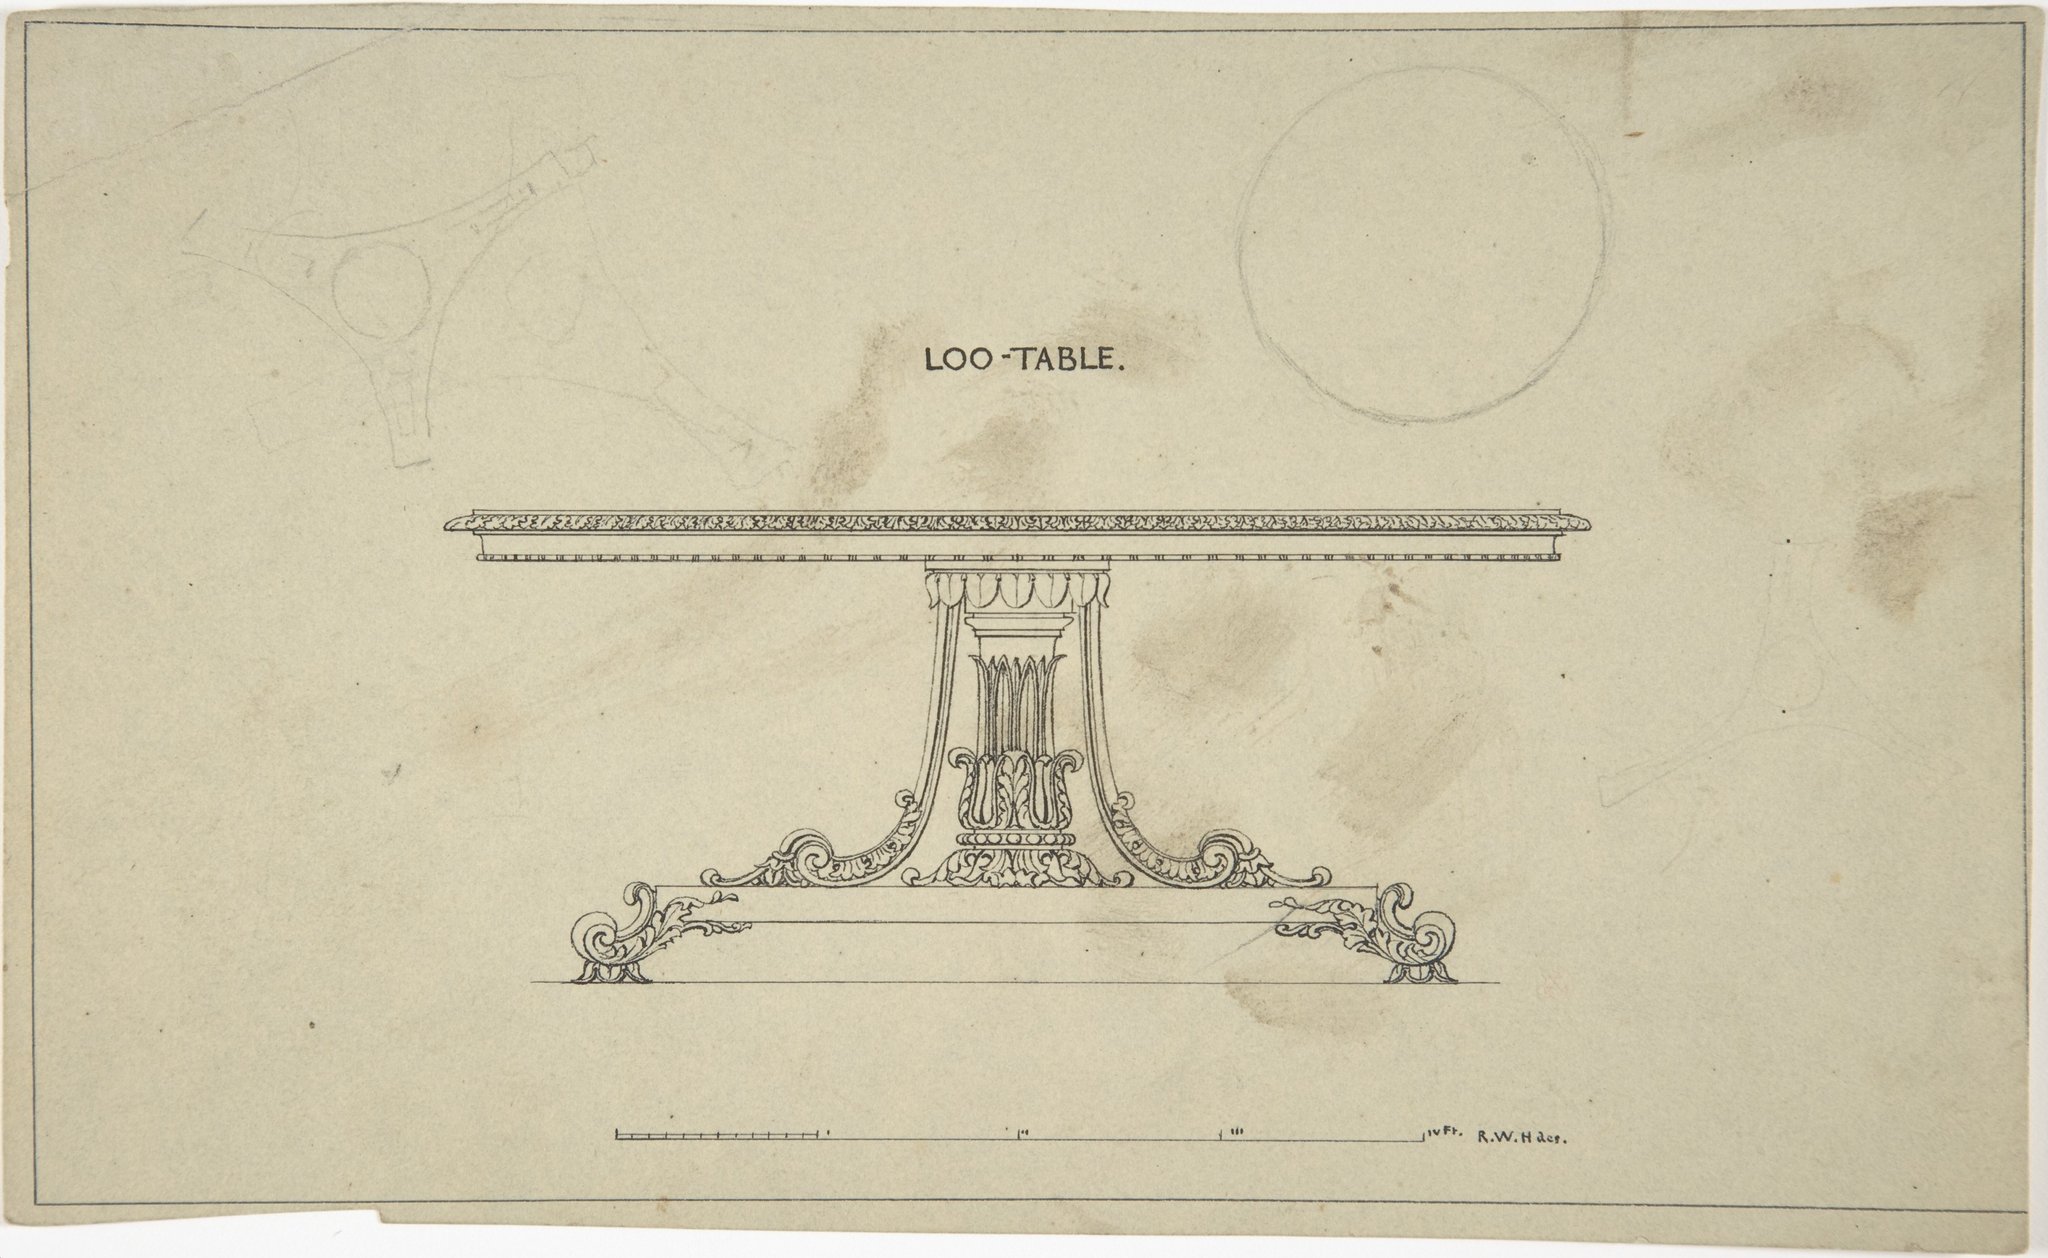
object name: drawing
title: Design for Loo-Table, with plans of top and pedestal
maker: robert william hume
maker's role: artist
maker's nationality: british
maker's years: 1816-1904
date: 1835-1900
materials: graphite, ink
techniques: pen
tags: tables